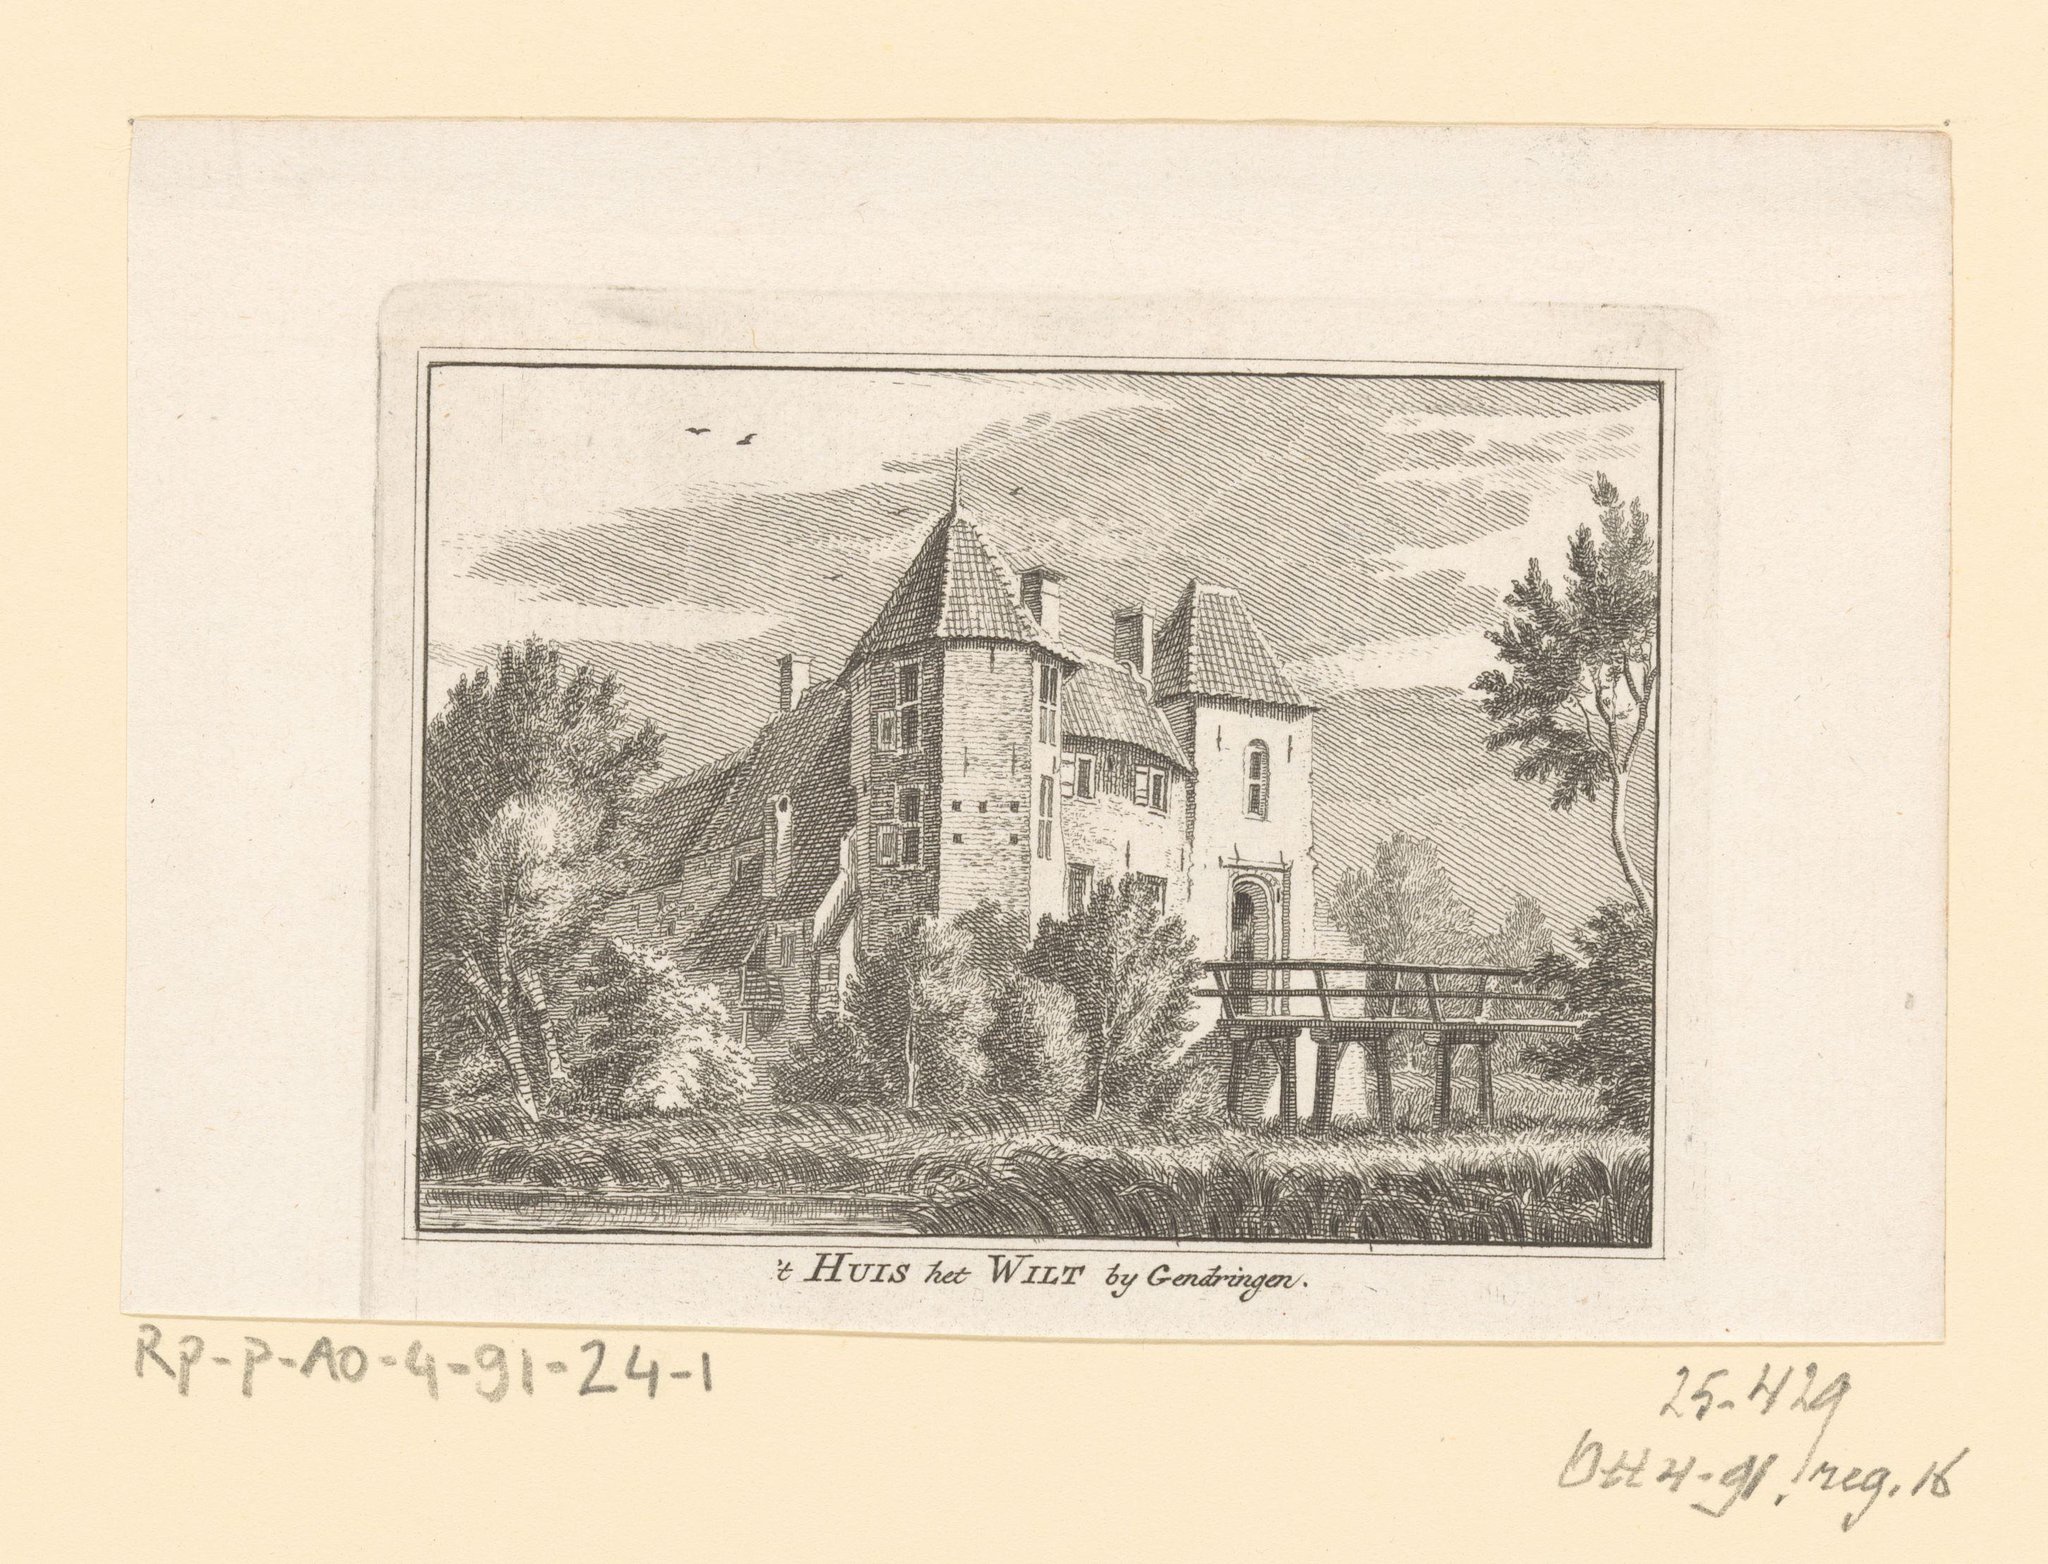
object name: print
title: 't Huis het Wilt by Gendringen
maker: hendrik spilman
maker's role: draughtsman, painter, print maker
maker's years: 1721-1784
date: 1745-1792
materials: paper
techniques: etching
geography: haarlem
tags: castle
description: Prent ook gebruikt in: Het verheerlykt Nederland of kabinet van hedendaagsche gezigten van steden, dorpen (…). 9 delen. Amsterdam: Isaak Tirion en weduwe Isaak Tirion, 1745-1774, dl. 1 (1745), ill. 69. Of in: Nederlandsche tafereelen; of eene keurige verzameling van negen honderd fraaije gezigten van steden, dorpen, sloten, oudheden (….). 9 delen. Amsterdam: Jan de Groot, 1792, dl. 1, ill. 69.